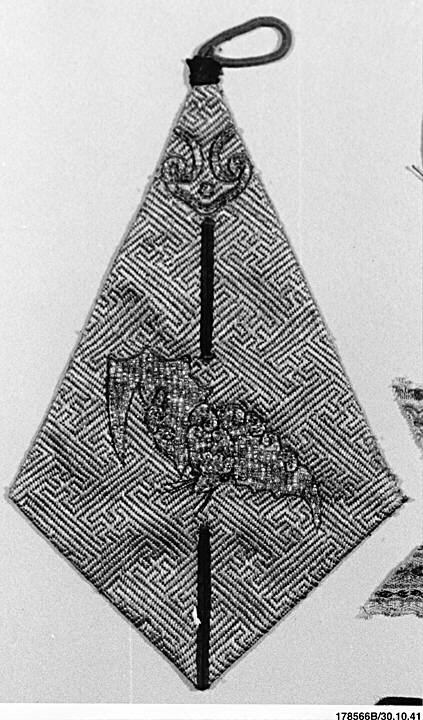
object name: hanging case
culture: chinese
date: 1801-1900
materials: glass, silk